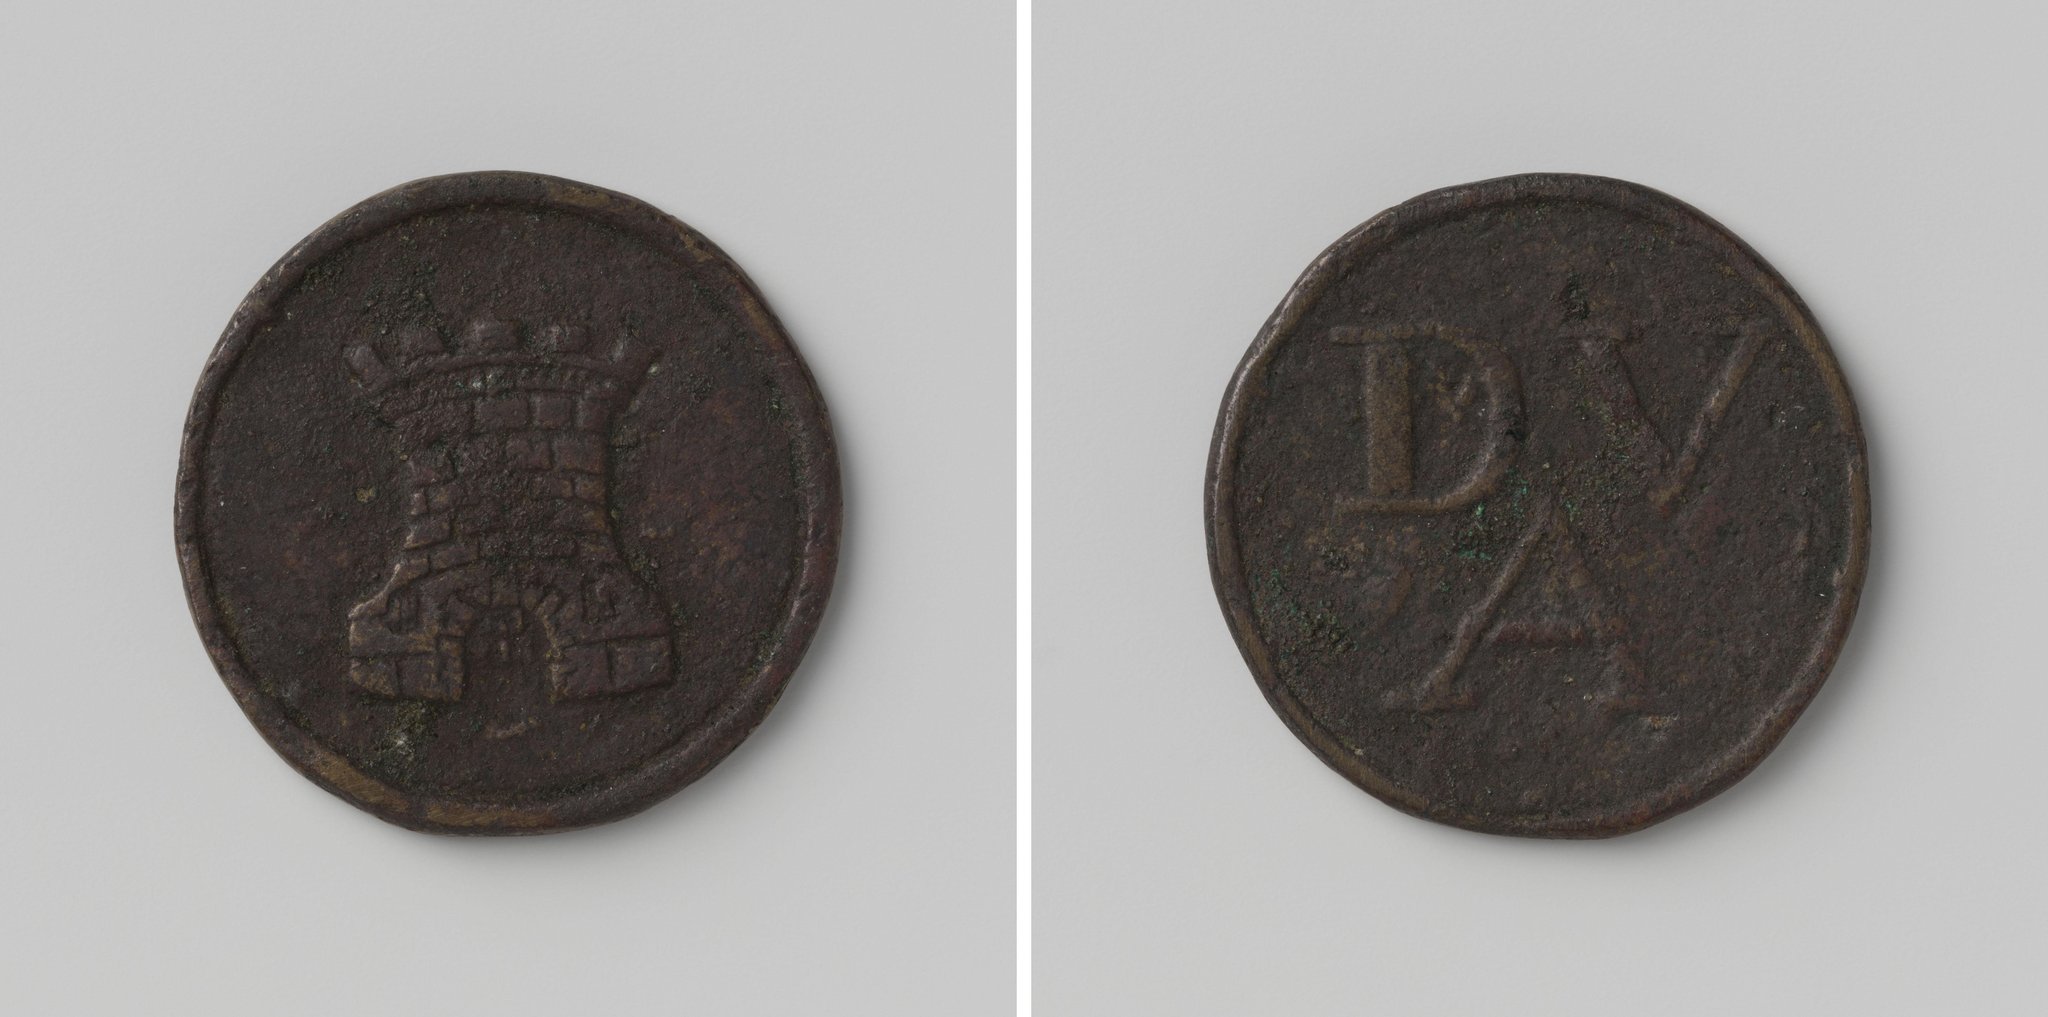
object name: armenloodje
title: Diaconie van Alkmaar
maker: Anonymous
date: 1600-1800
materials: brass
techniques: casting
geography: alkmaar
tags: alkmaar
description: Messing penning. Voorzijde: burcht. Keerzijde: letters D en V, boven letter A.